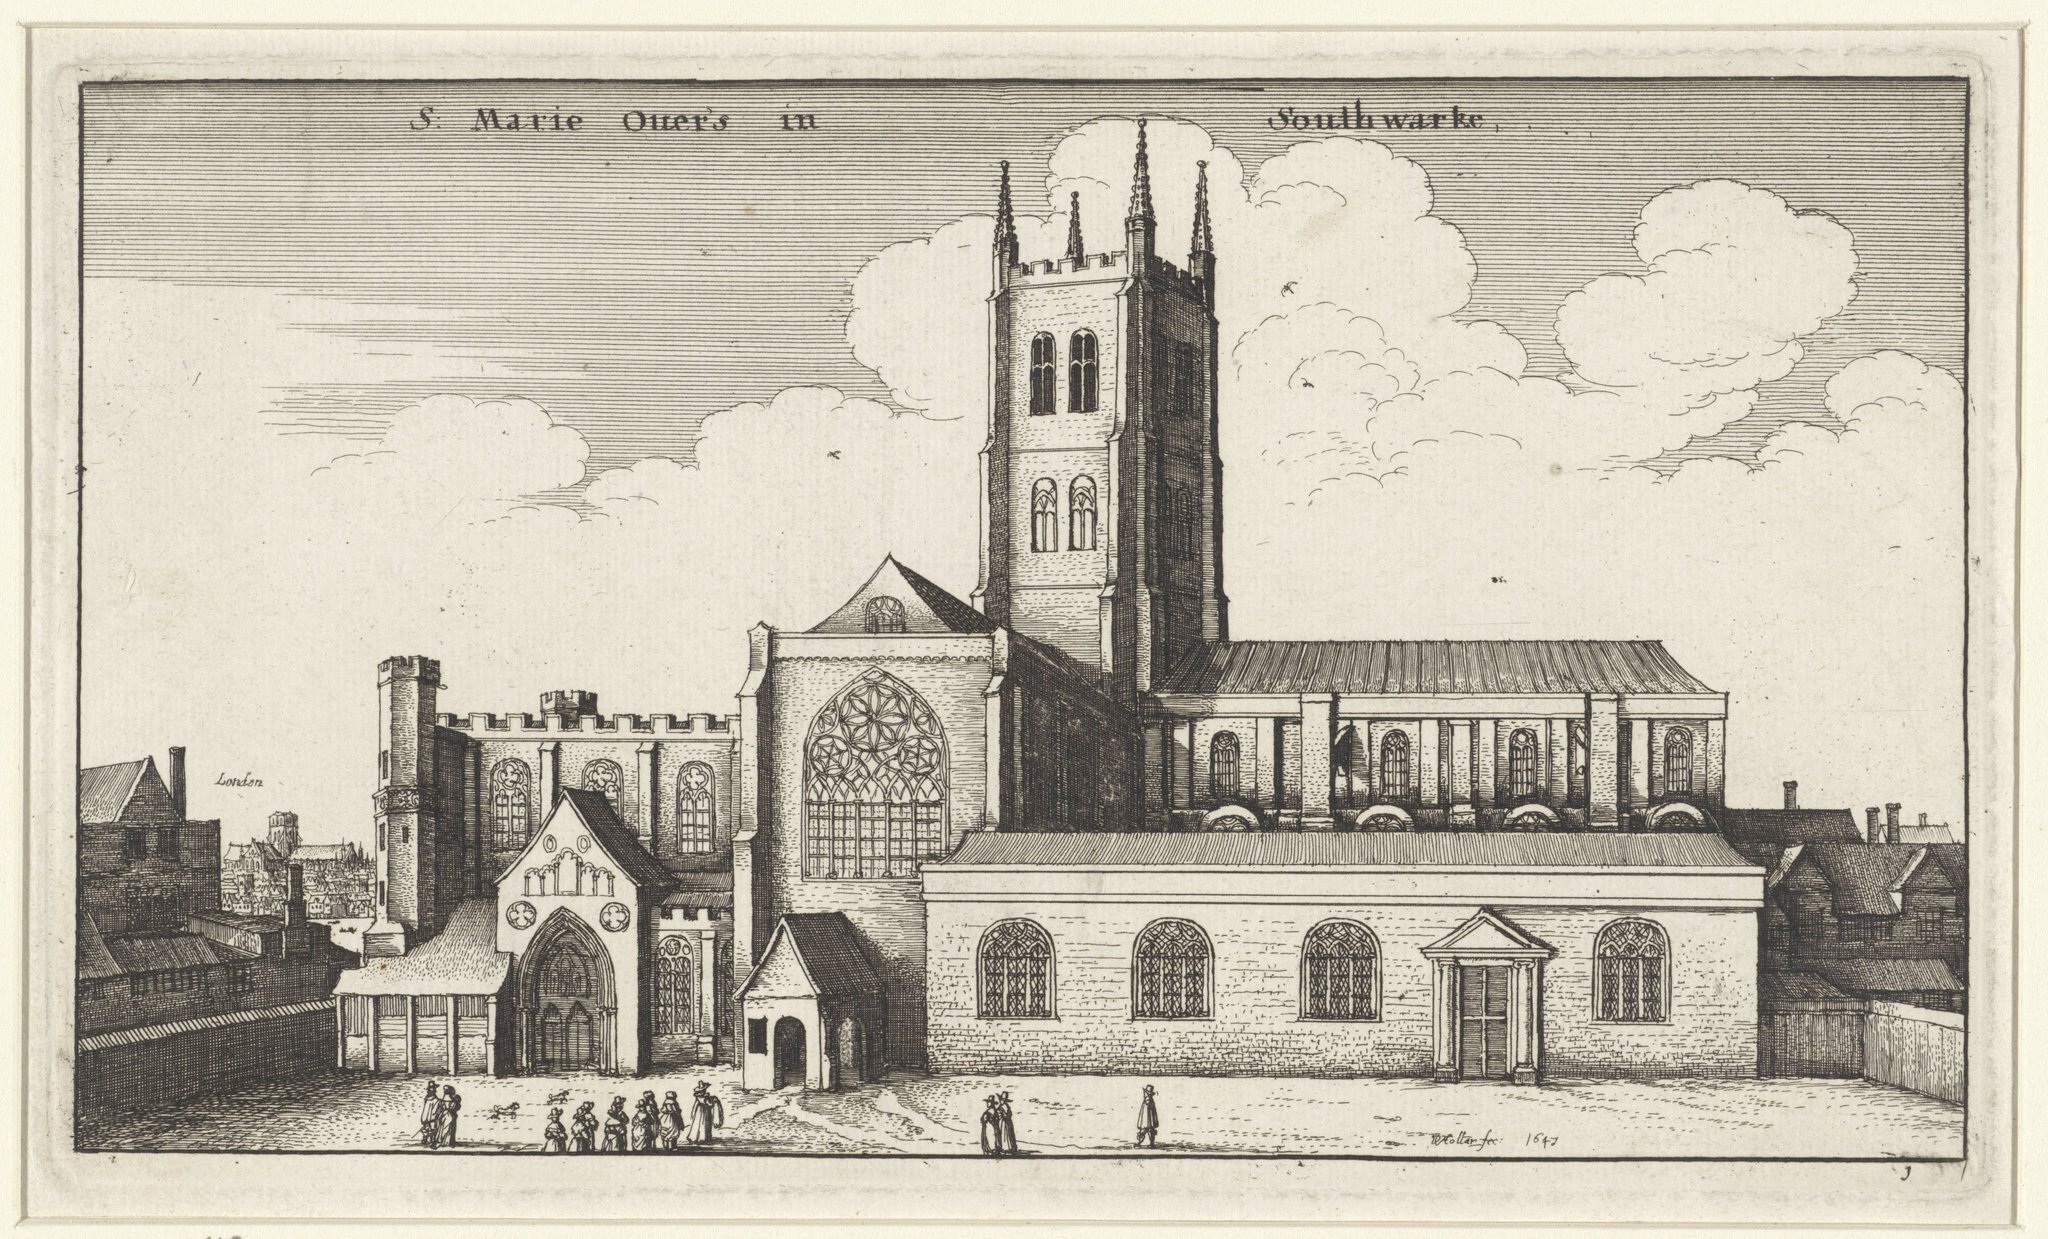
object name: print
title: Gezicht op de Southwark Cathedral in Londen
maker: wenceslaus hollar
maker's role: draughtsman, print maker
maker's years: 1607-1677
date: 1647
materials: paper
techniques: etching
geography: antwerp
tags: church (exterior)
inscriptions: collector's mark: Lugt 654